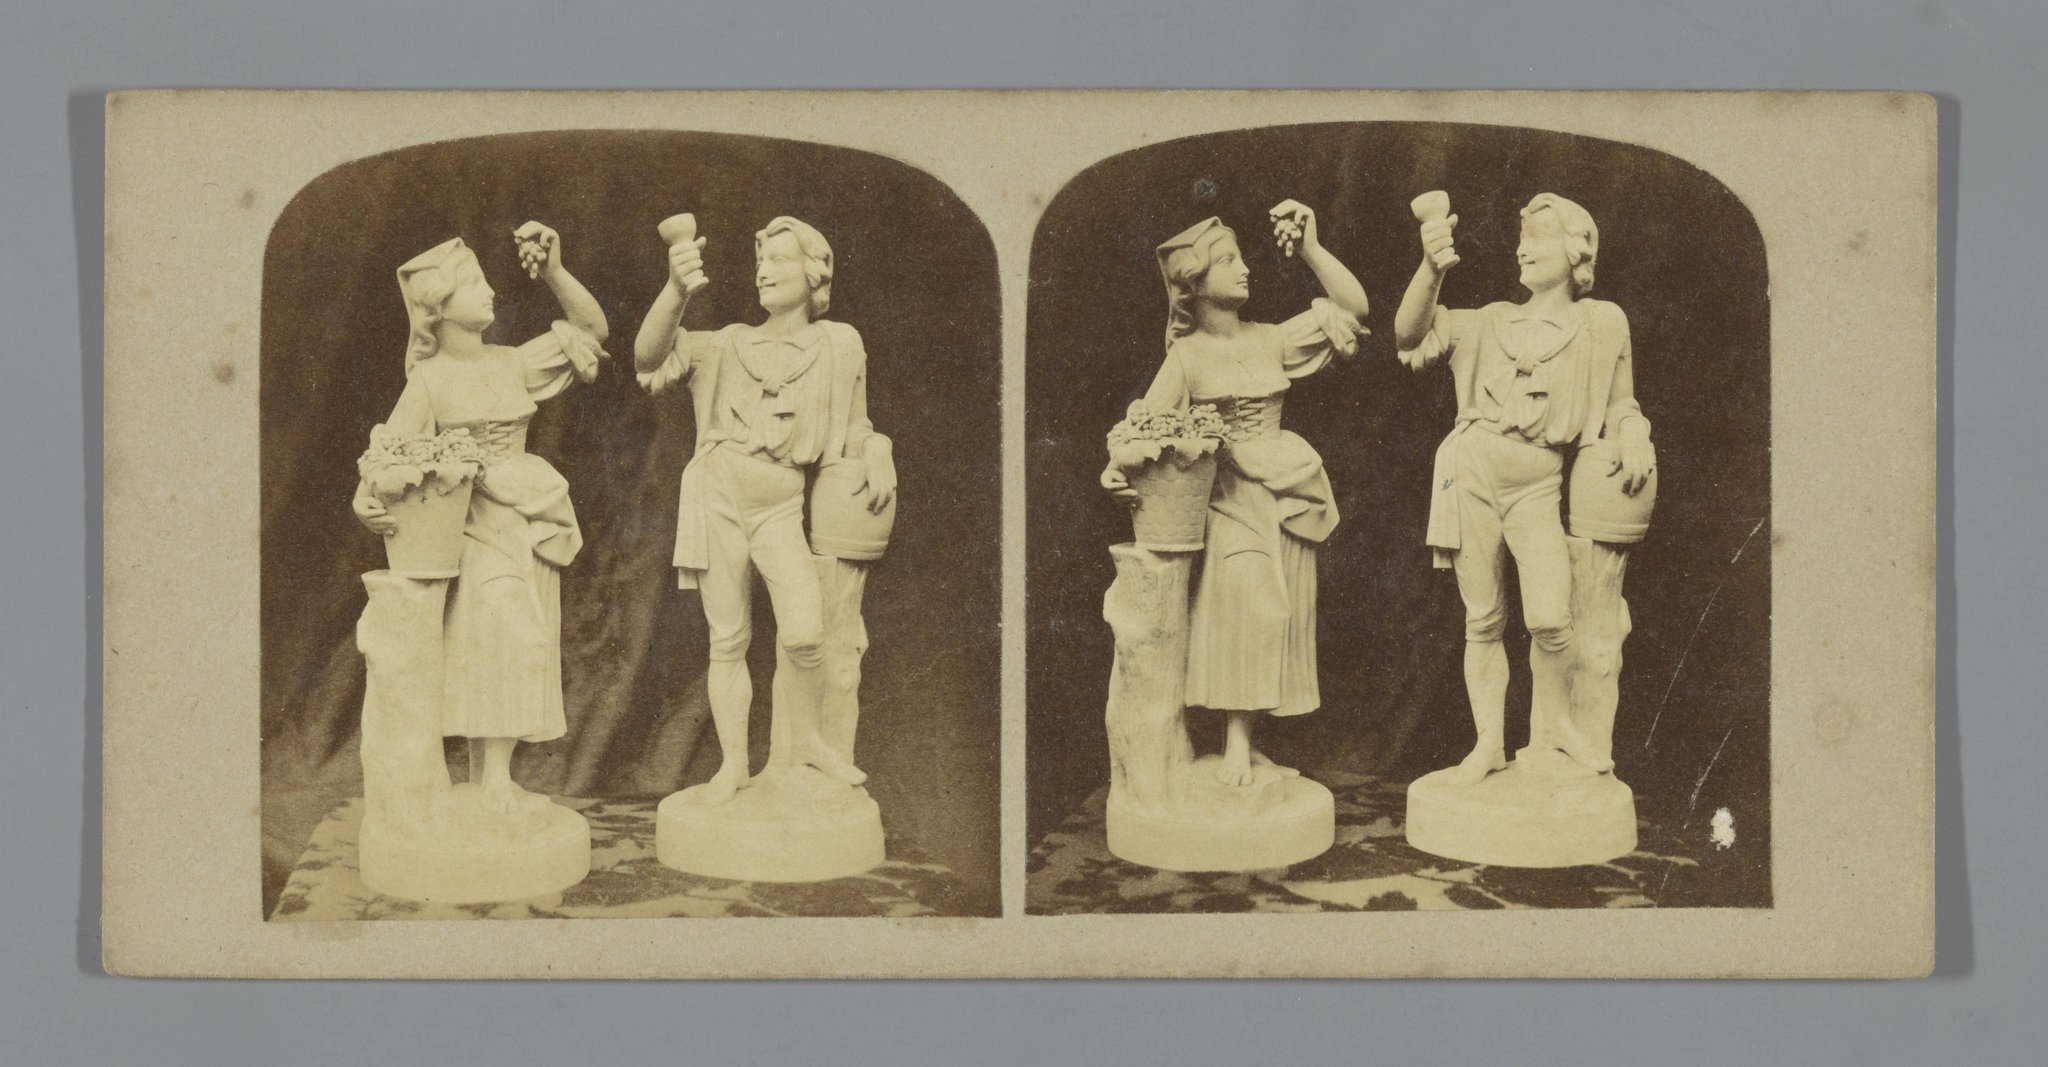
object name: stereograph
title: Italian Peasants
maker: Anonymous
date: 1855-1880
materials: cardboard, photographic support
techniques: albumen print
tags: folk costume, regional costume, sculpture